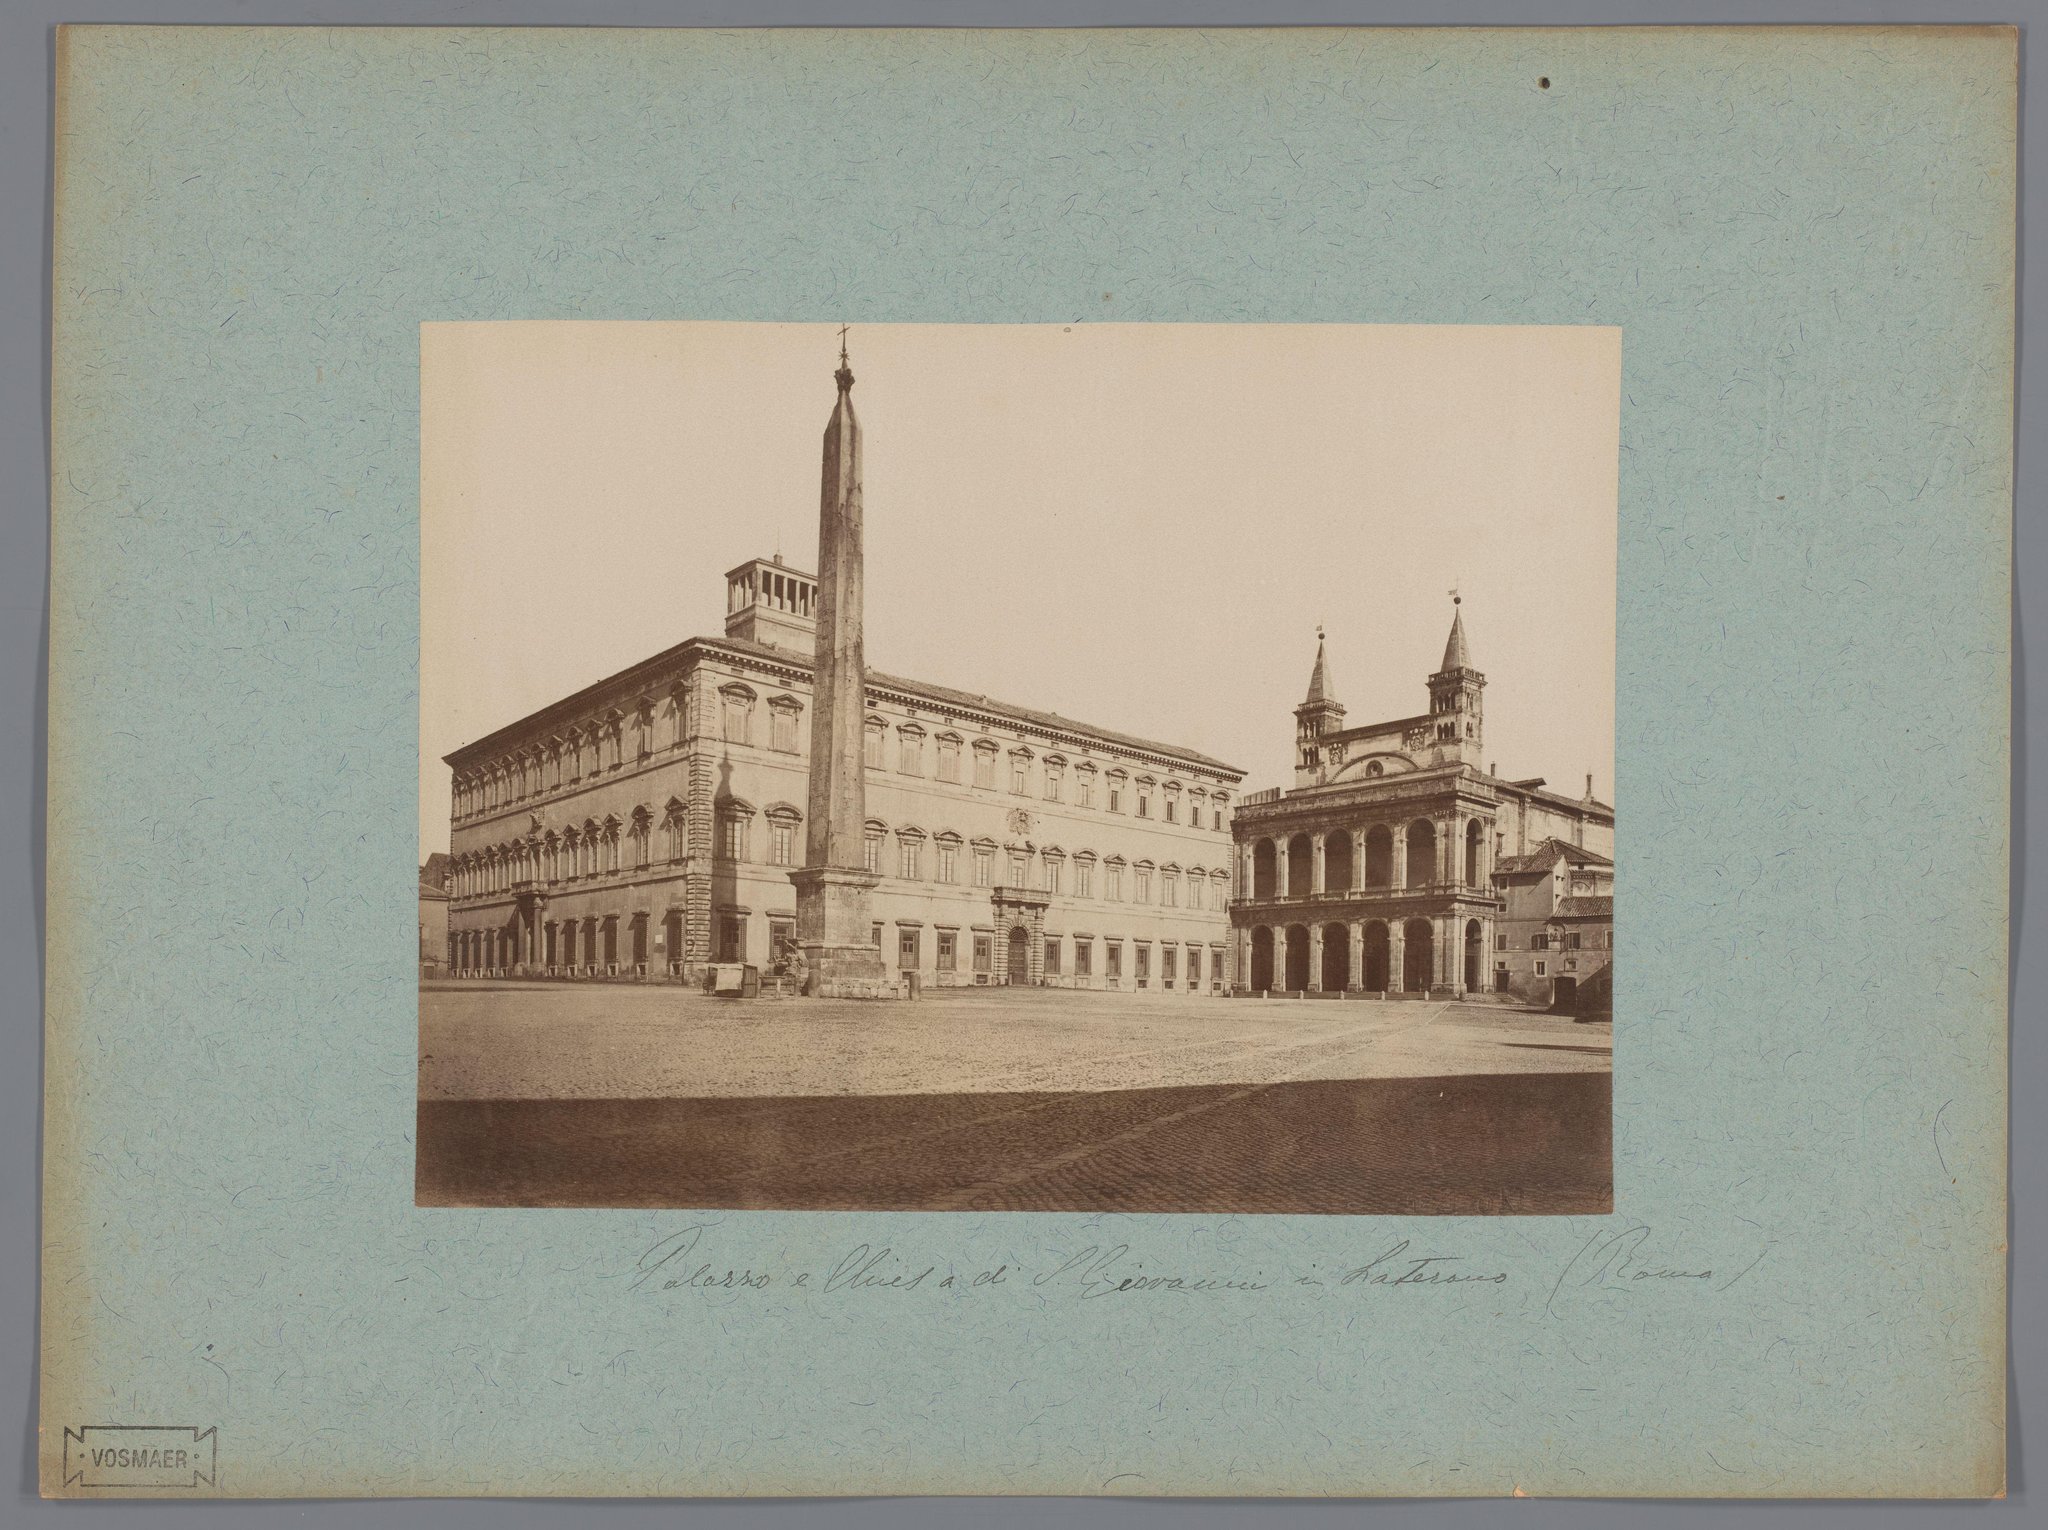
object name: photograph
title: Sint-Jan van Lateranen en het Lateraans Paleis te Rome, Italië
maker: Anonymous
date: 1851-1900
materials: cardboard, paper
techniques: albumen print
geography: rome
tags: palace, church (exterior)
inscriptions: collector's mark: ‘VOSMAER’, number: ‘144 No [?]’, inscription: ‘Palazzo e Chiesa di Giovanni in Laterano (Roma)’